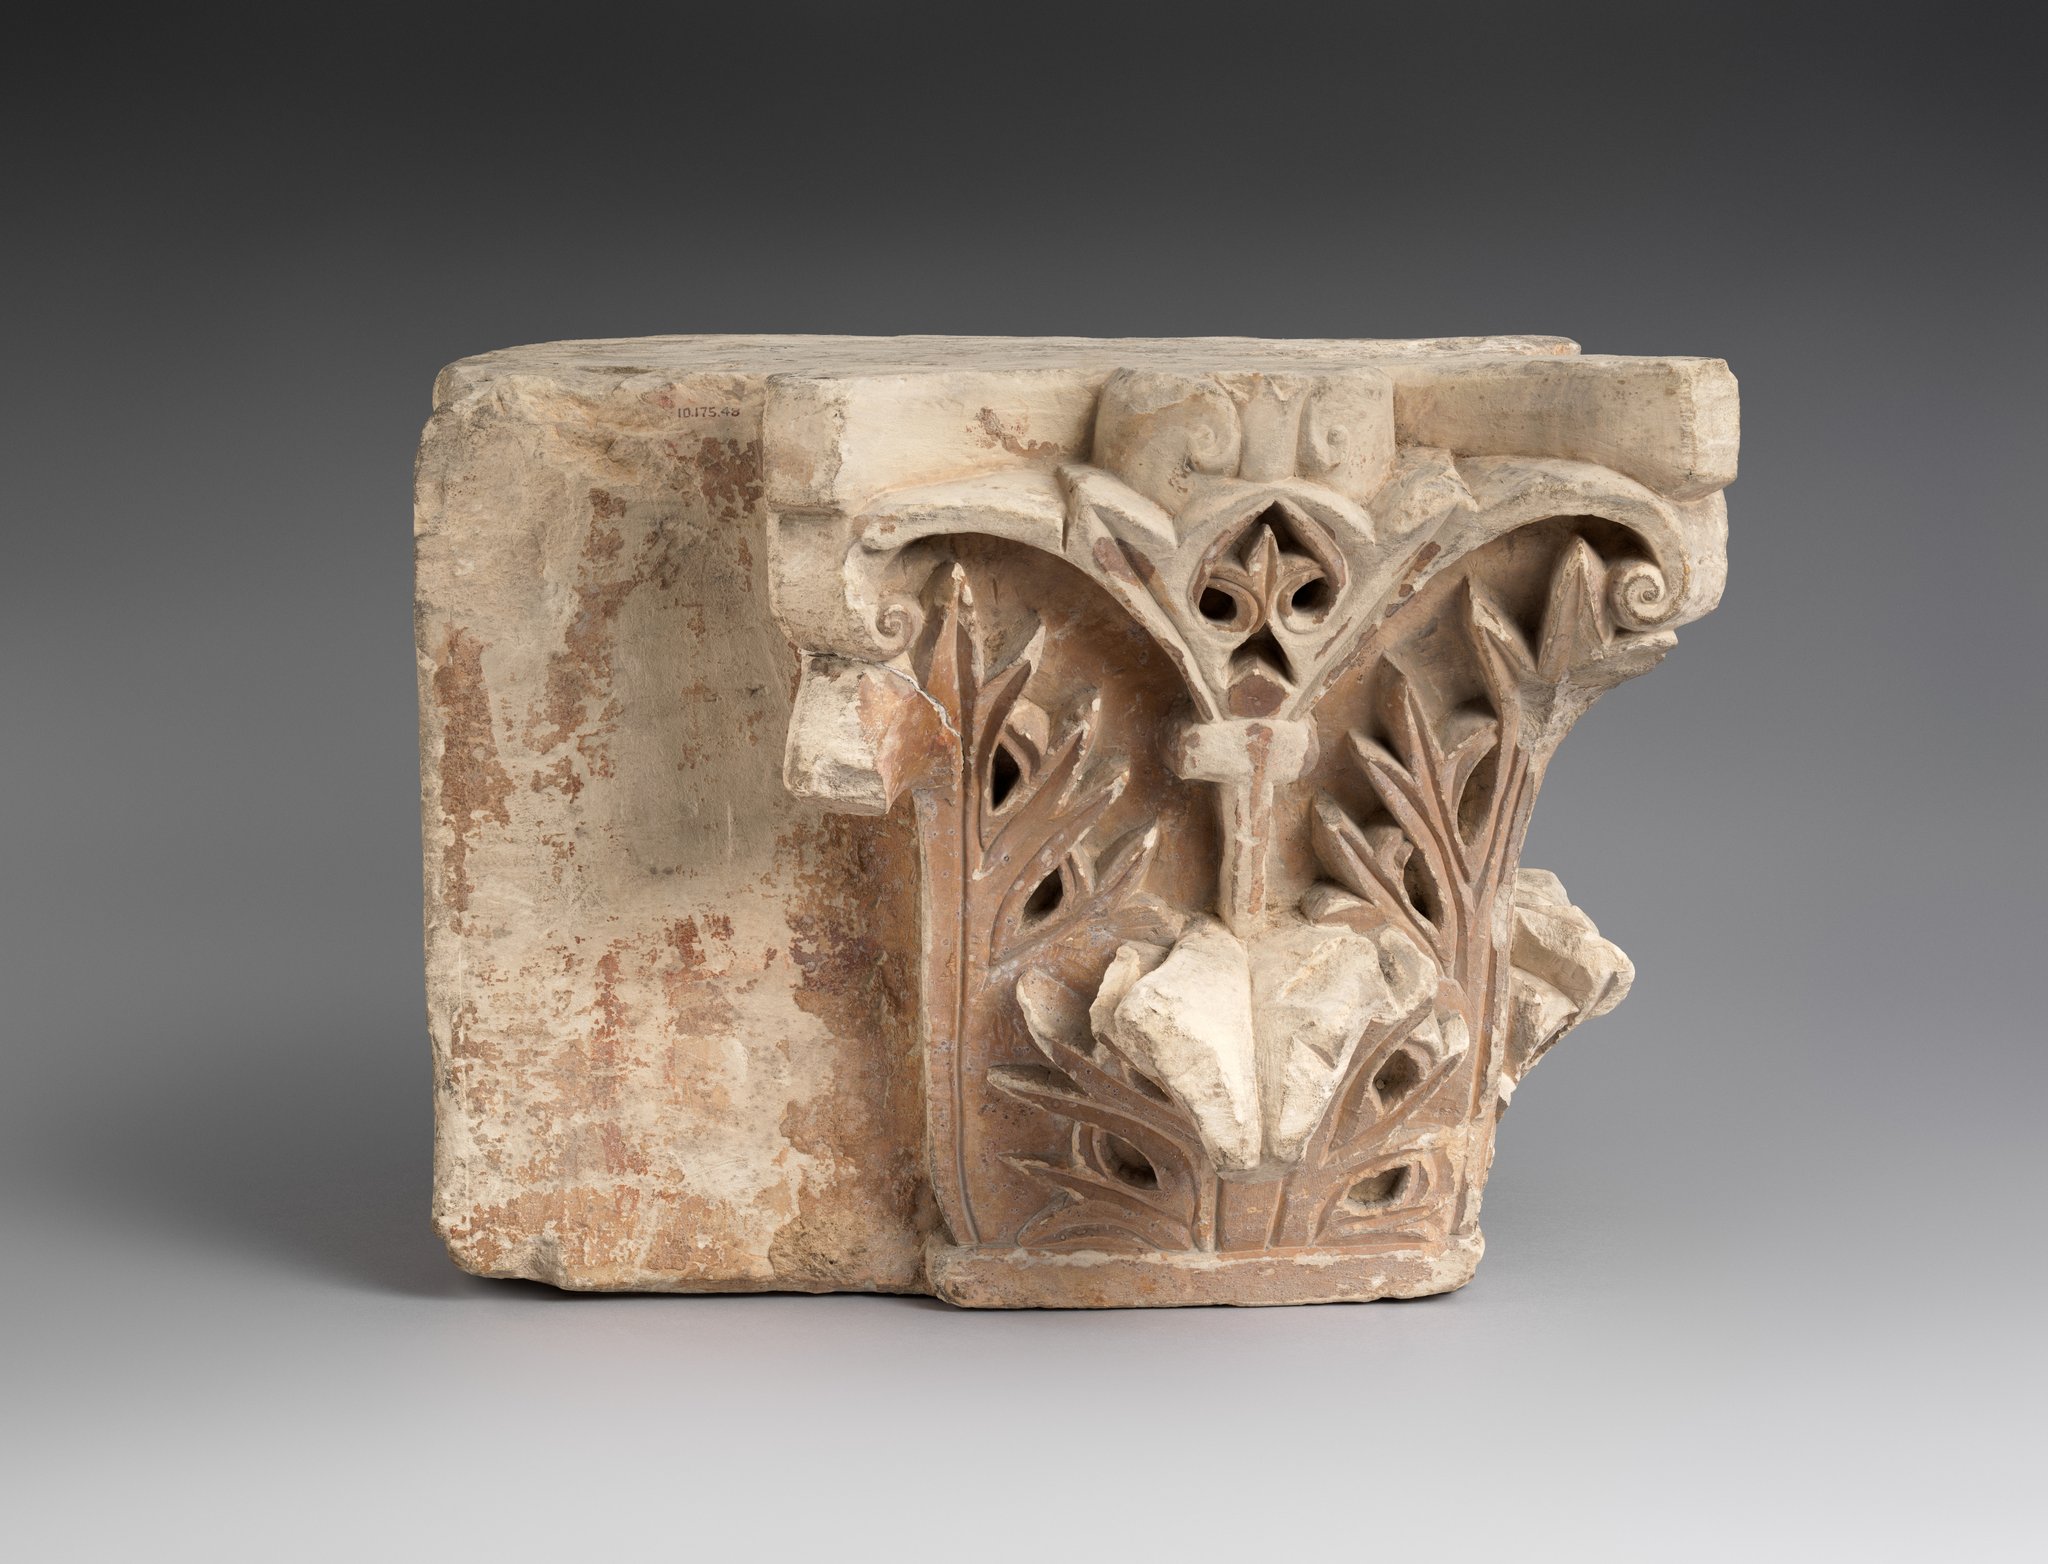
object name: capital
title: Capital with Acanthus Leaves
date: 501-600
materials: limestone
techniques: carving, relief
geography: egypt